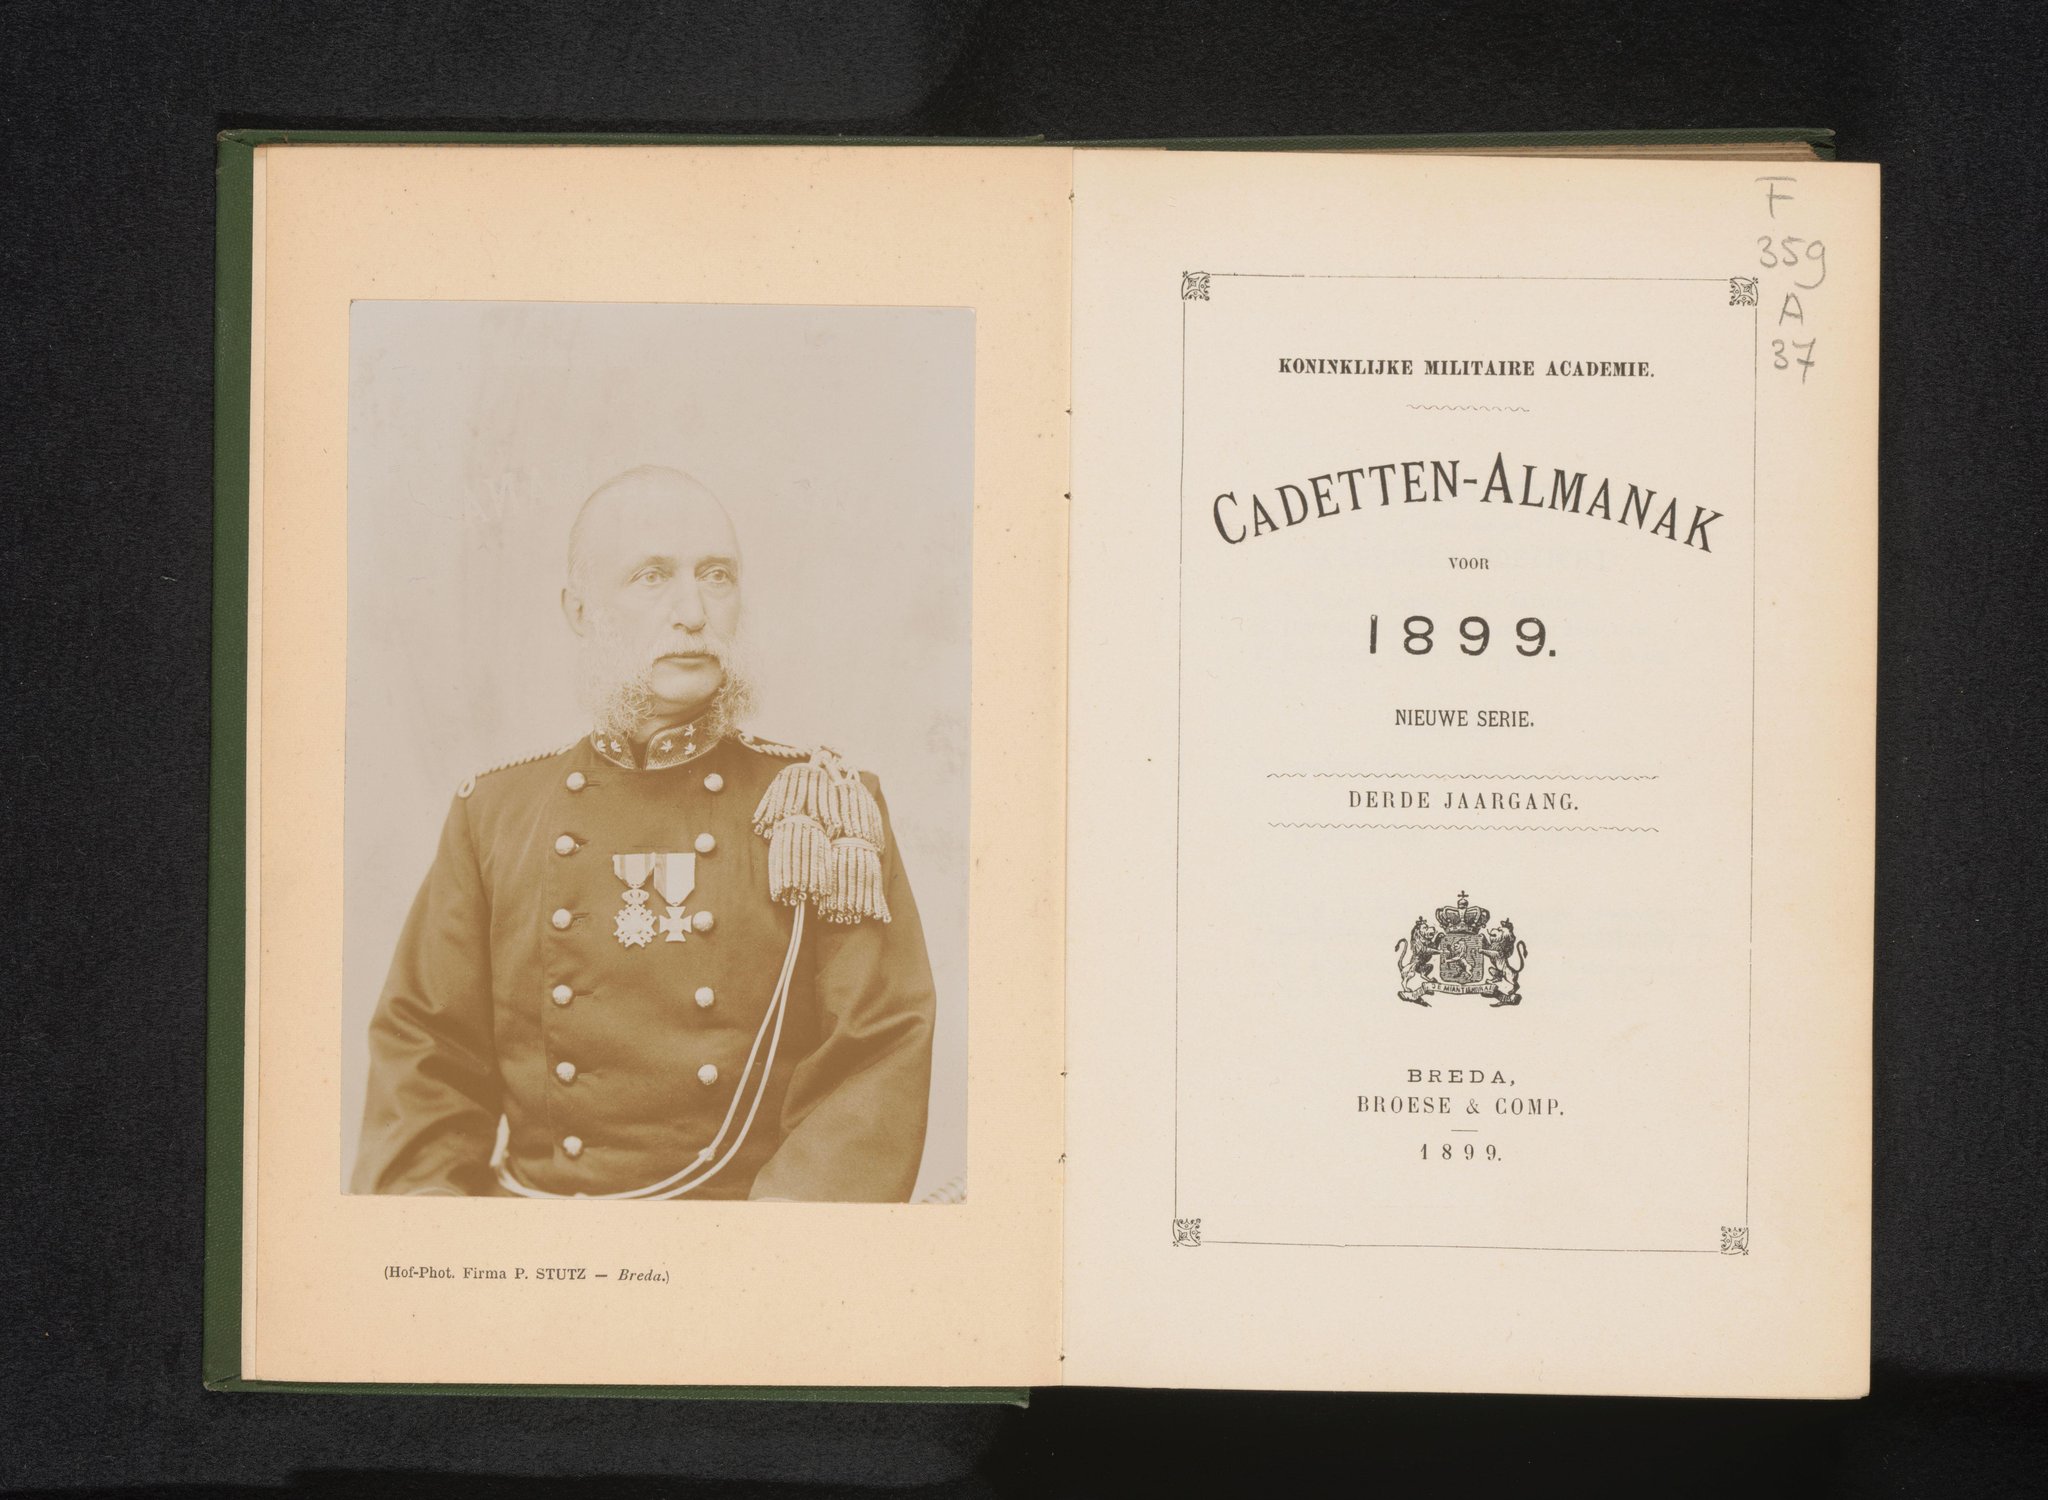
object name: book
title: Cadetten-almanak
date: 1899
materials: cardboard, linen, paper, photographic support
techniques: photograph, decorated paper, printing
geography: breda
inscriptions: name: ‘Massink/ 3.1.'99.’